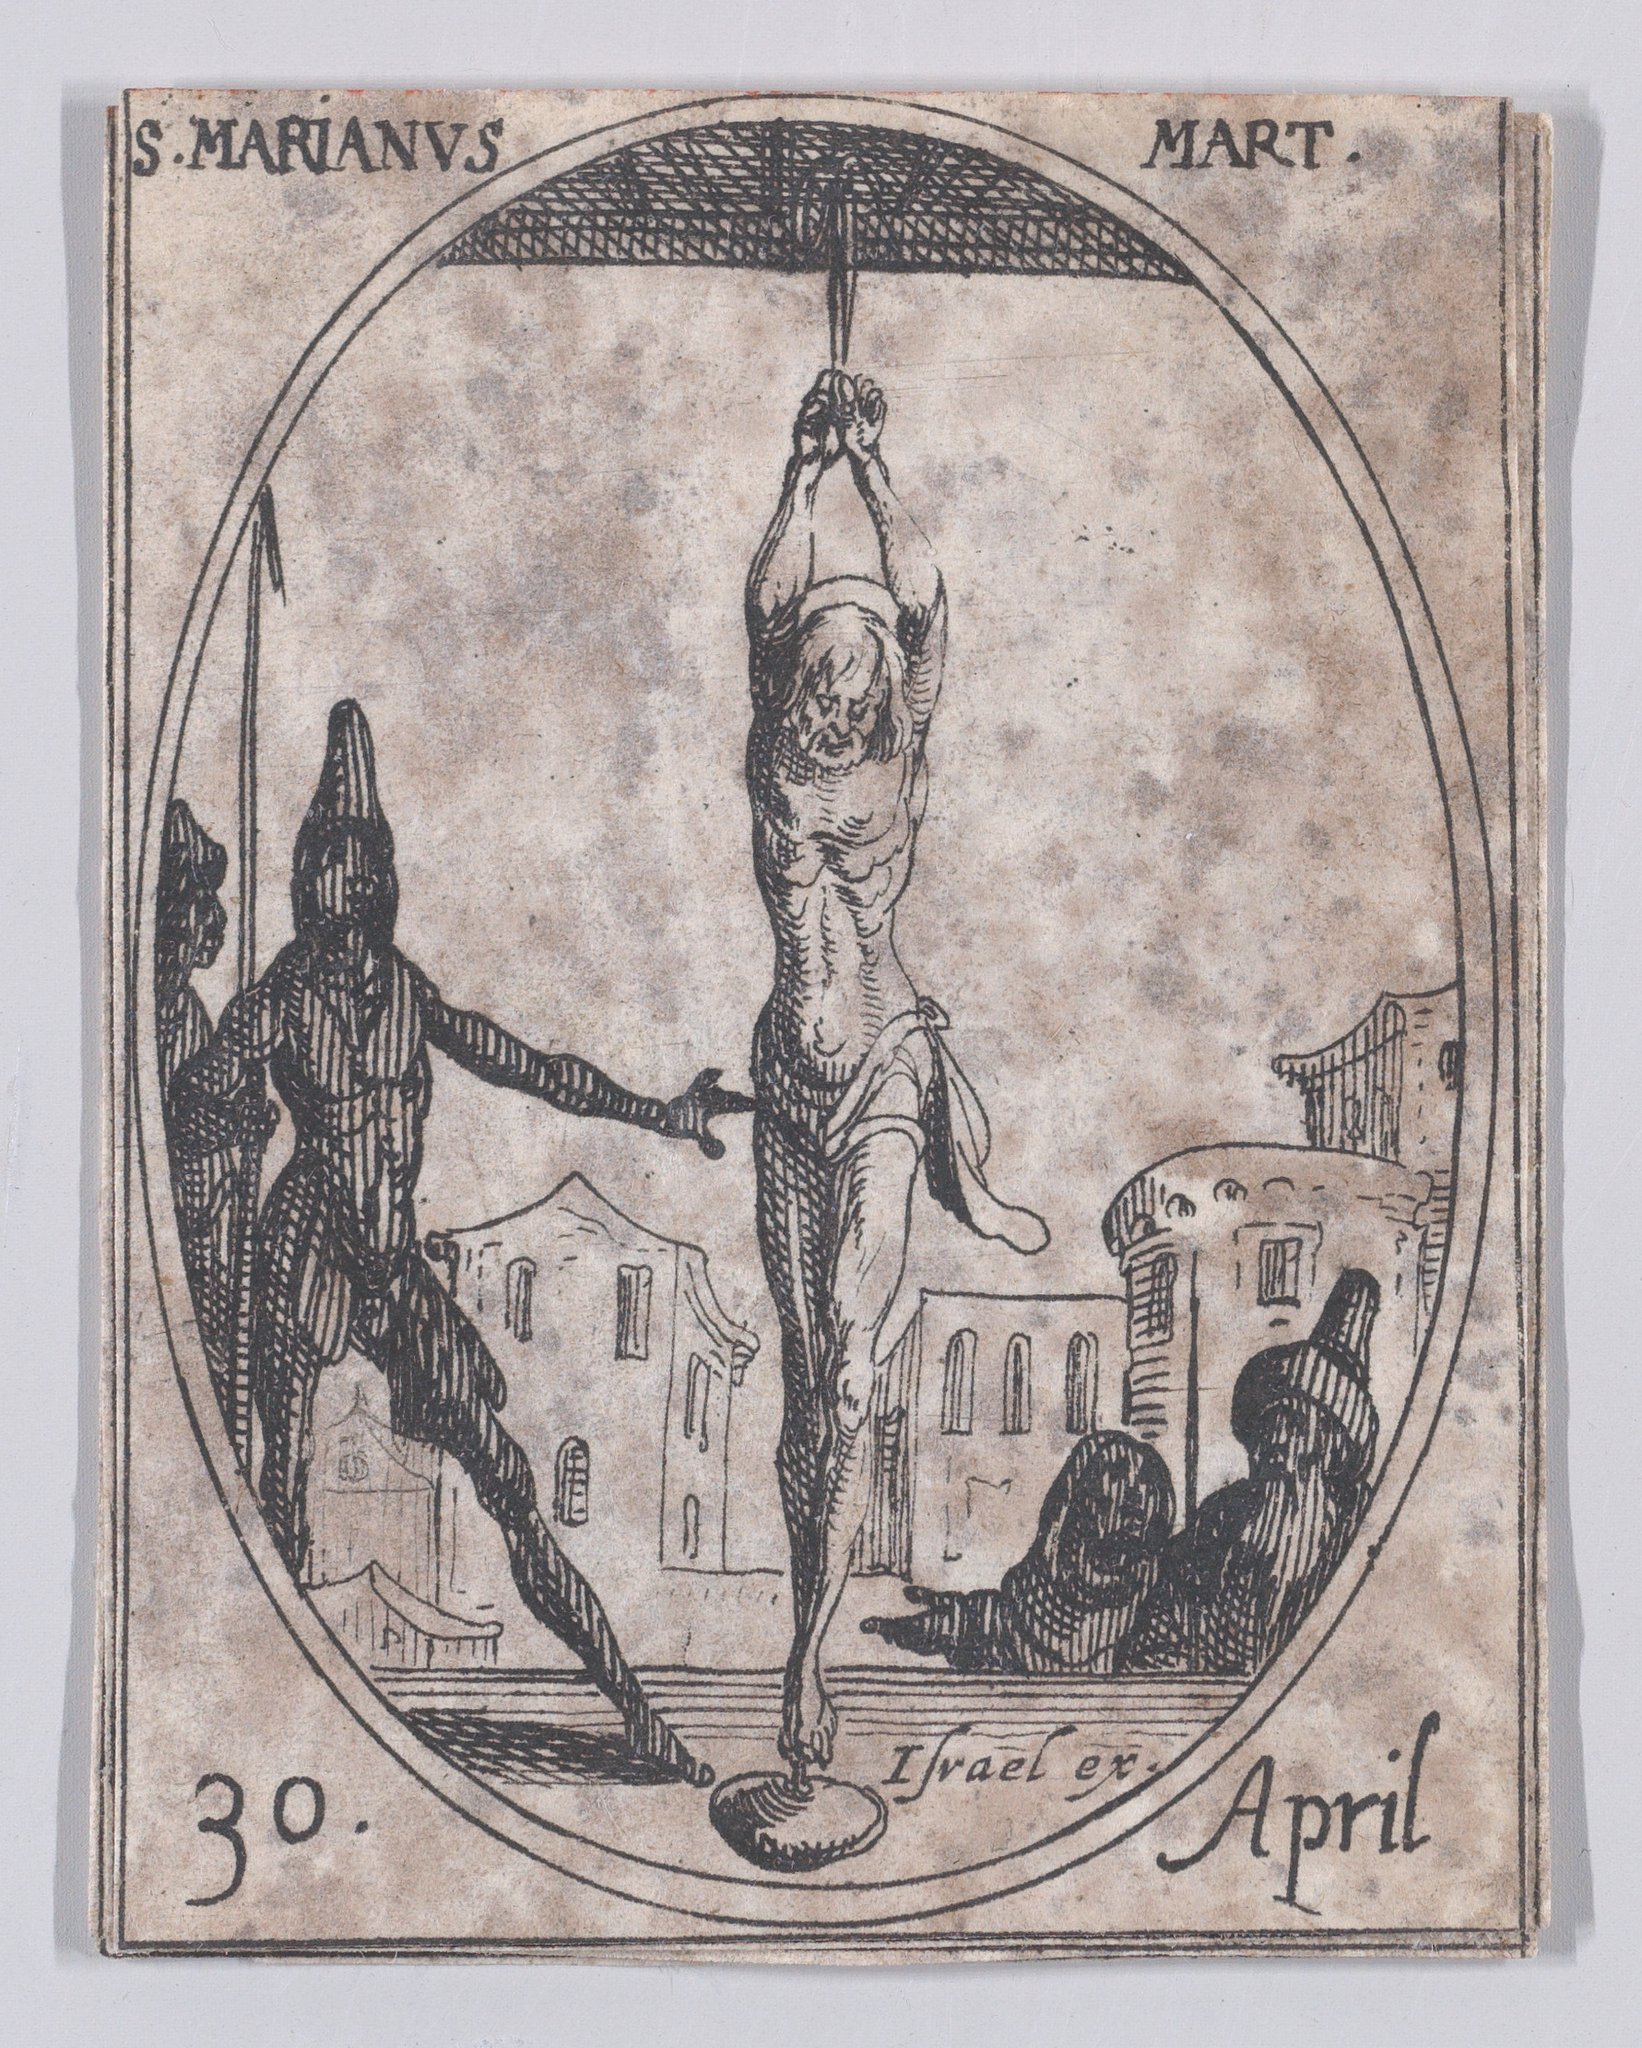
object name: print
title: S. Marien, martyre (St. Marianus, Martyr), April 30th, from "Les Images De Tous Les Saincts et Saintes de L'Année" (Images of All of the Saints and Religious Events of the Year)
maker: jacques callot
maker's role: artist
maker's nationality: french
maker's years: 1592-1635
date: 1636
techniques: etching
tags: men,saints